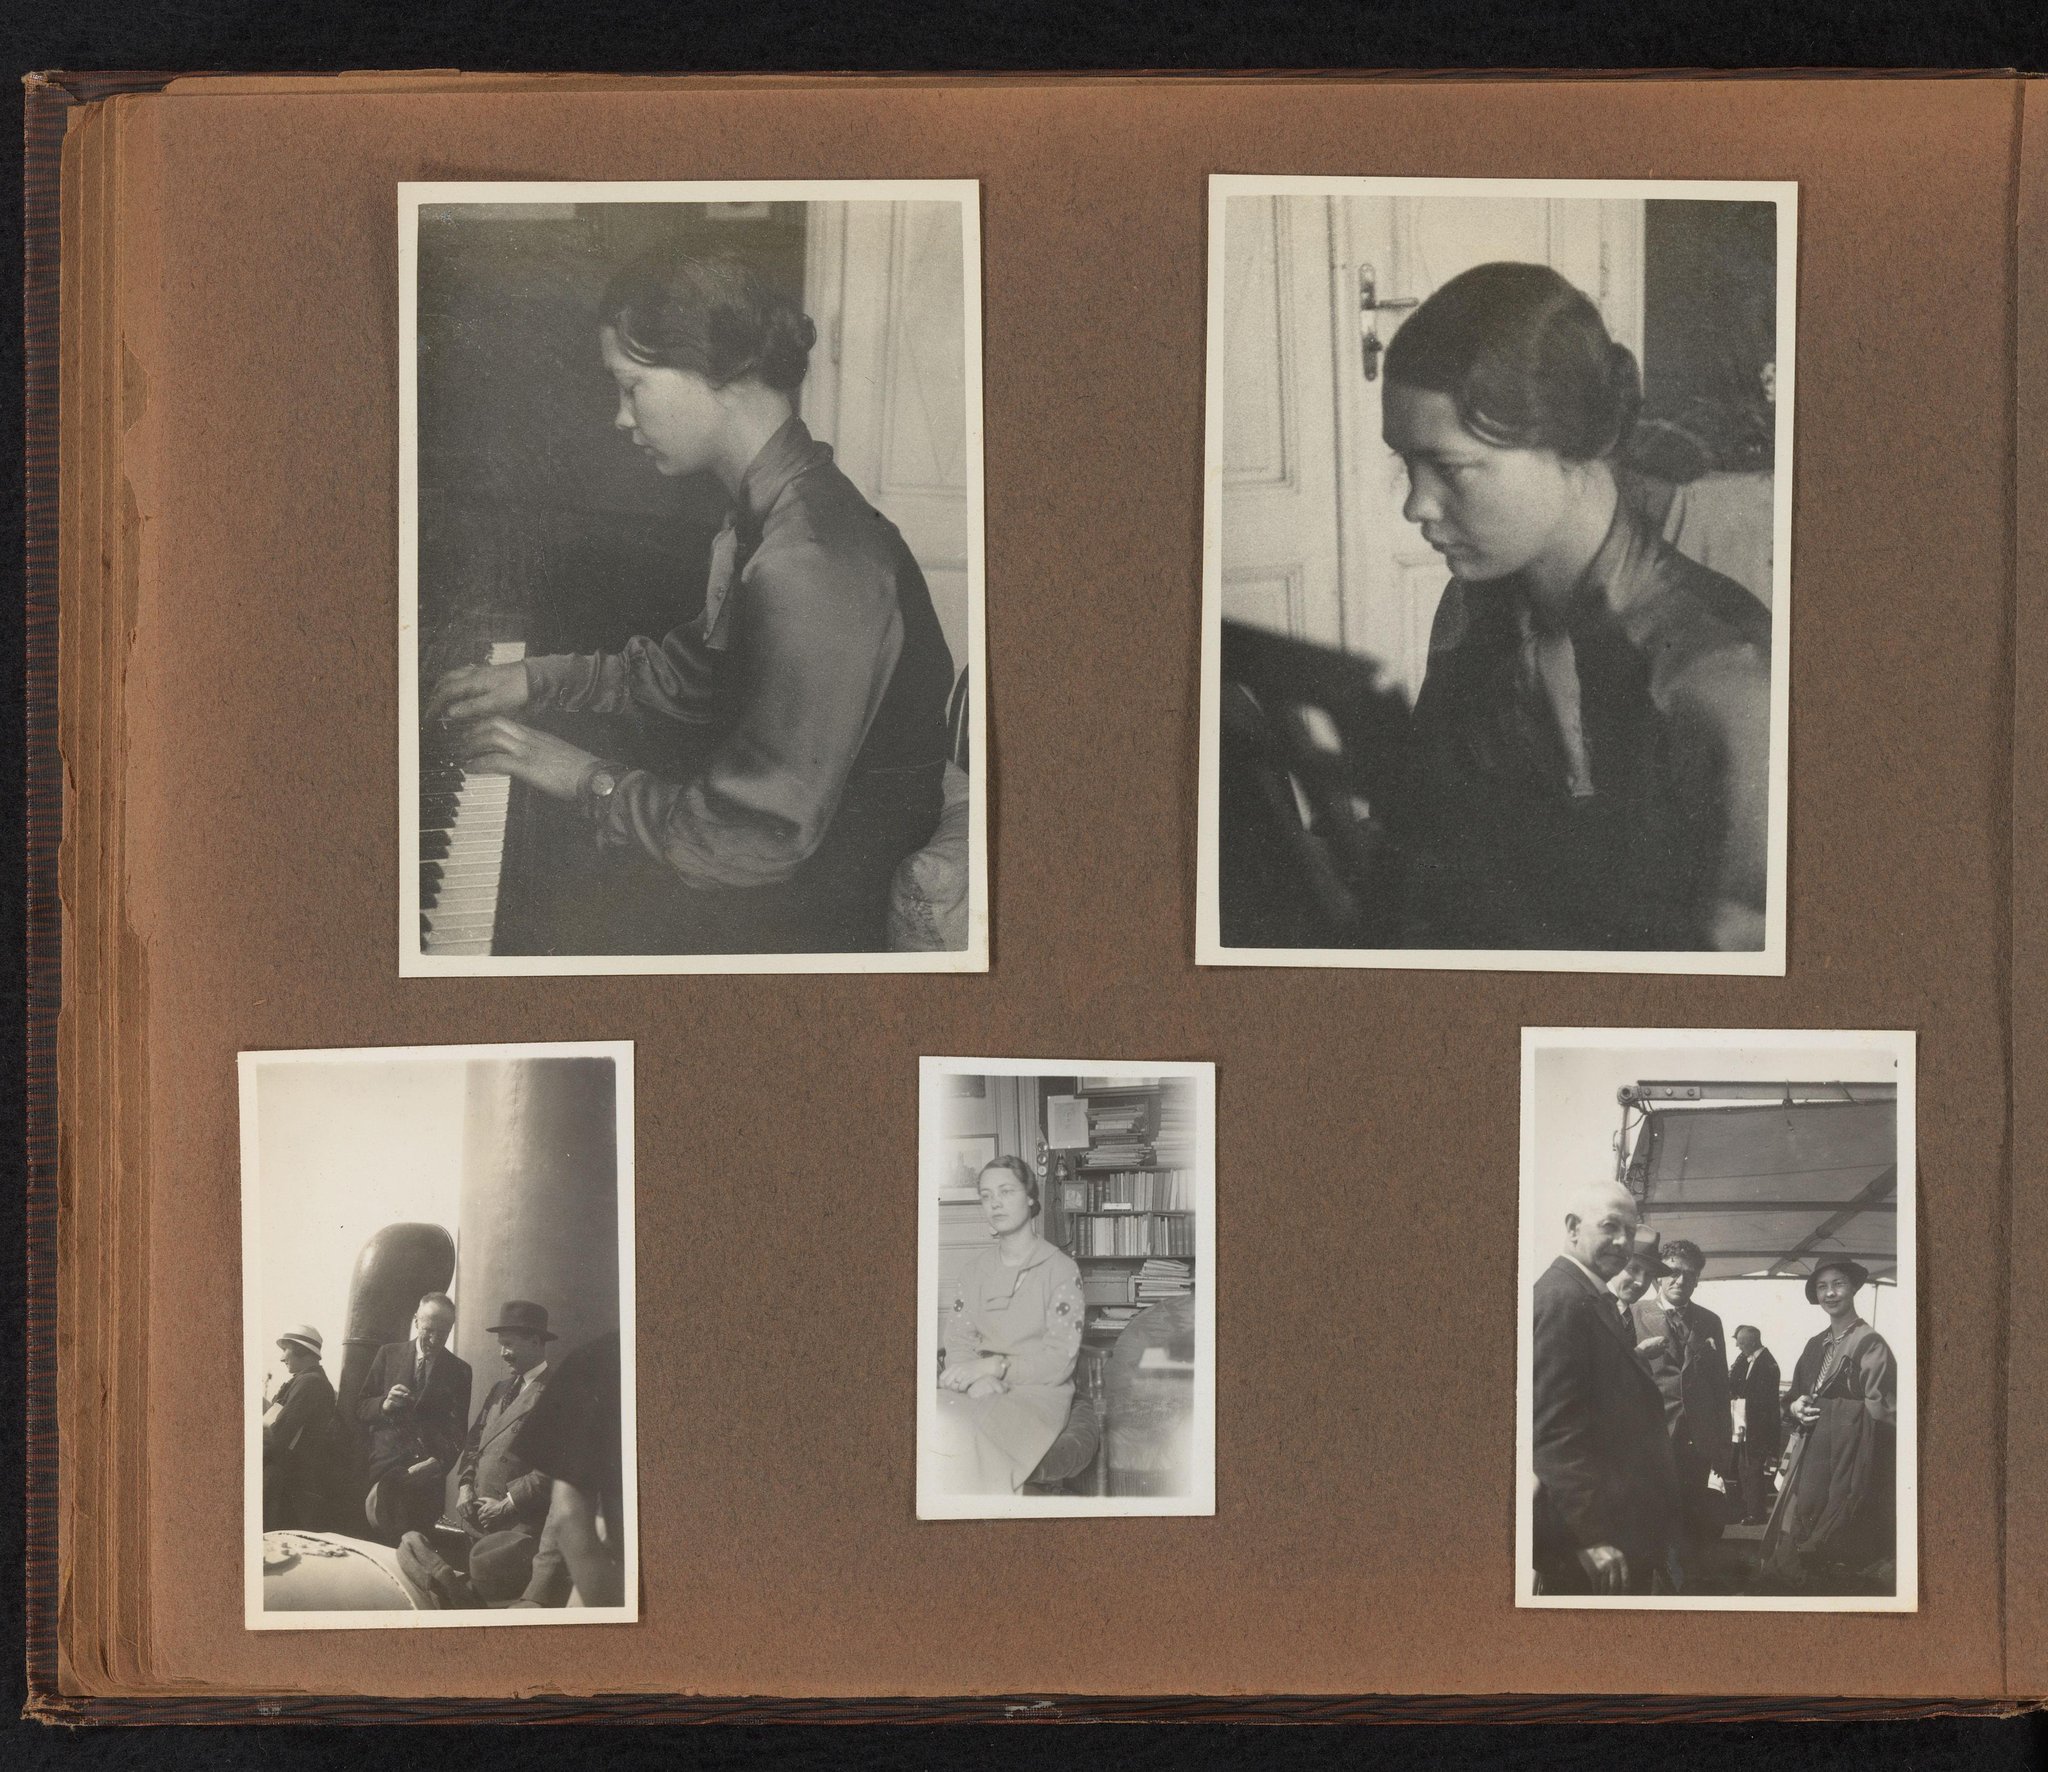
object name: album leaf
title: Bladzijde uit het fotoalbum van de familie Diepenbrock met 5 foto's van Alphons Diepenbrock en zijn omgeving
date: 1909-1920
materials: cardboard, photographic support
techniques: photography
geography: amsterdam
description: Bruin albumblad 54 van familiealbum van Alphons Diepenbrock.